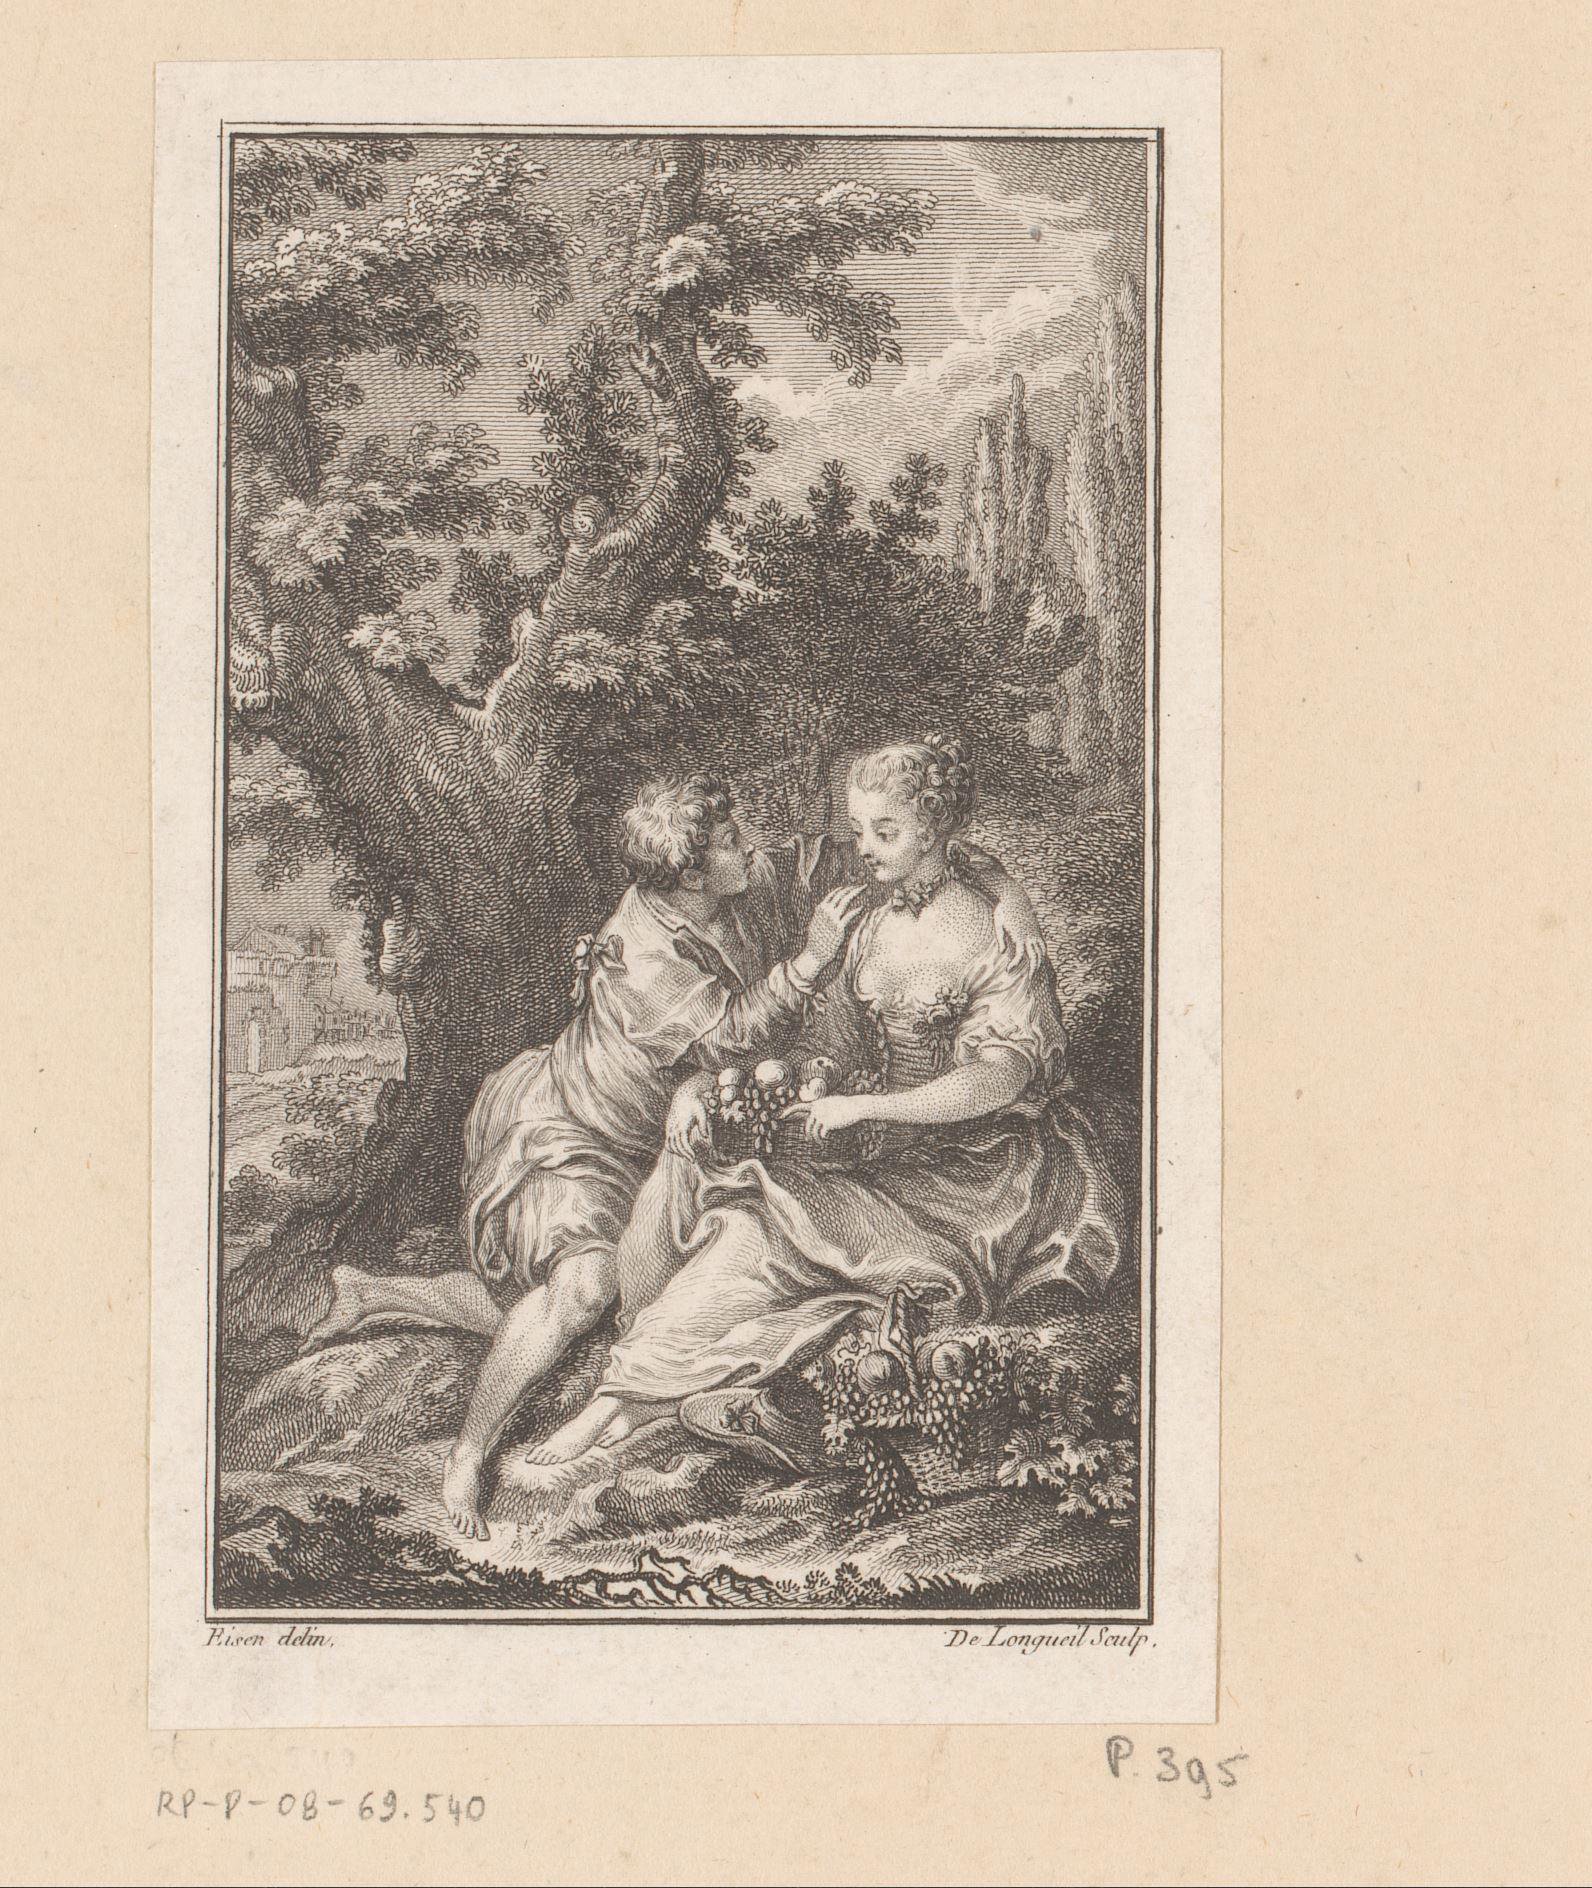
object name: print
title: Zintuigen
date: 1765-1792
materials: paper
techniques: engraving, etching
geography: france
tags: taste, tasting (one of the five senses)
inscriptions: collector's mark: Lugt 240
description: Mogelijk prent uit een boek of serie: 'Les sens'.